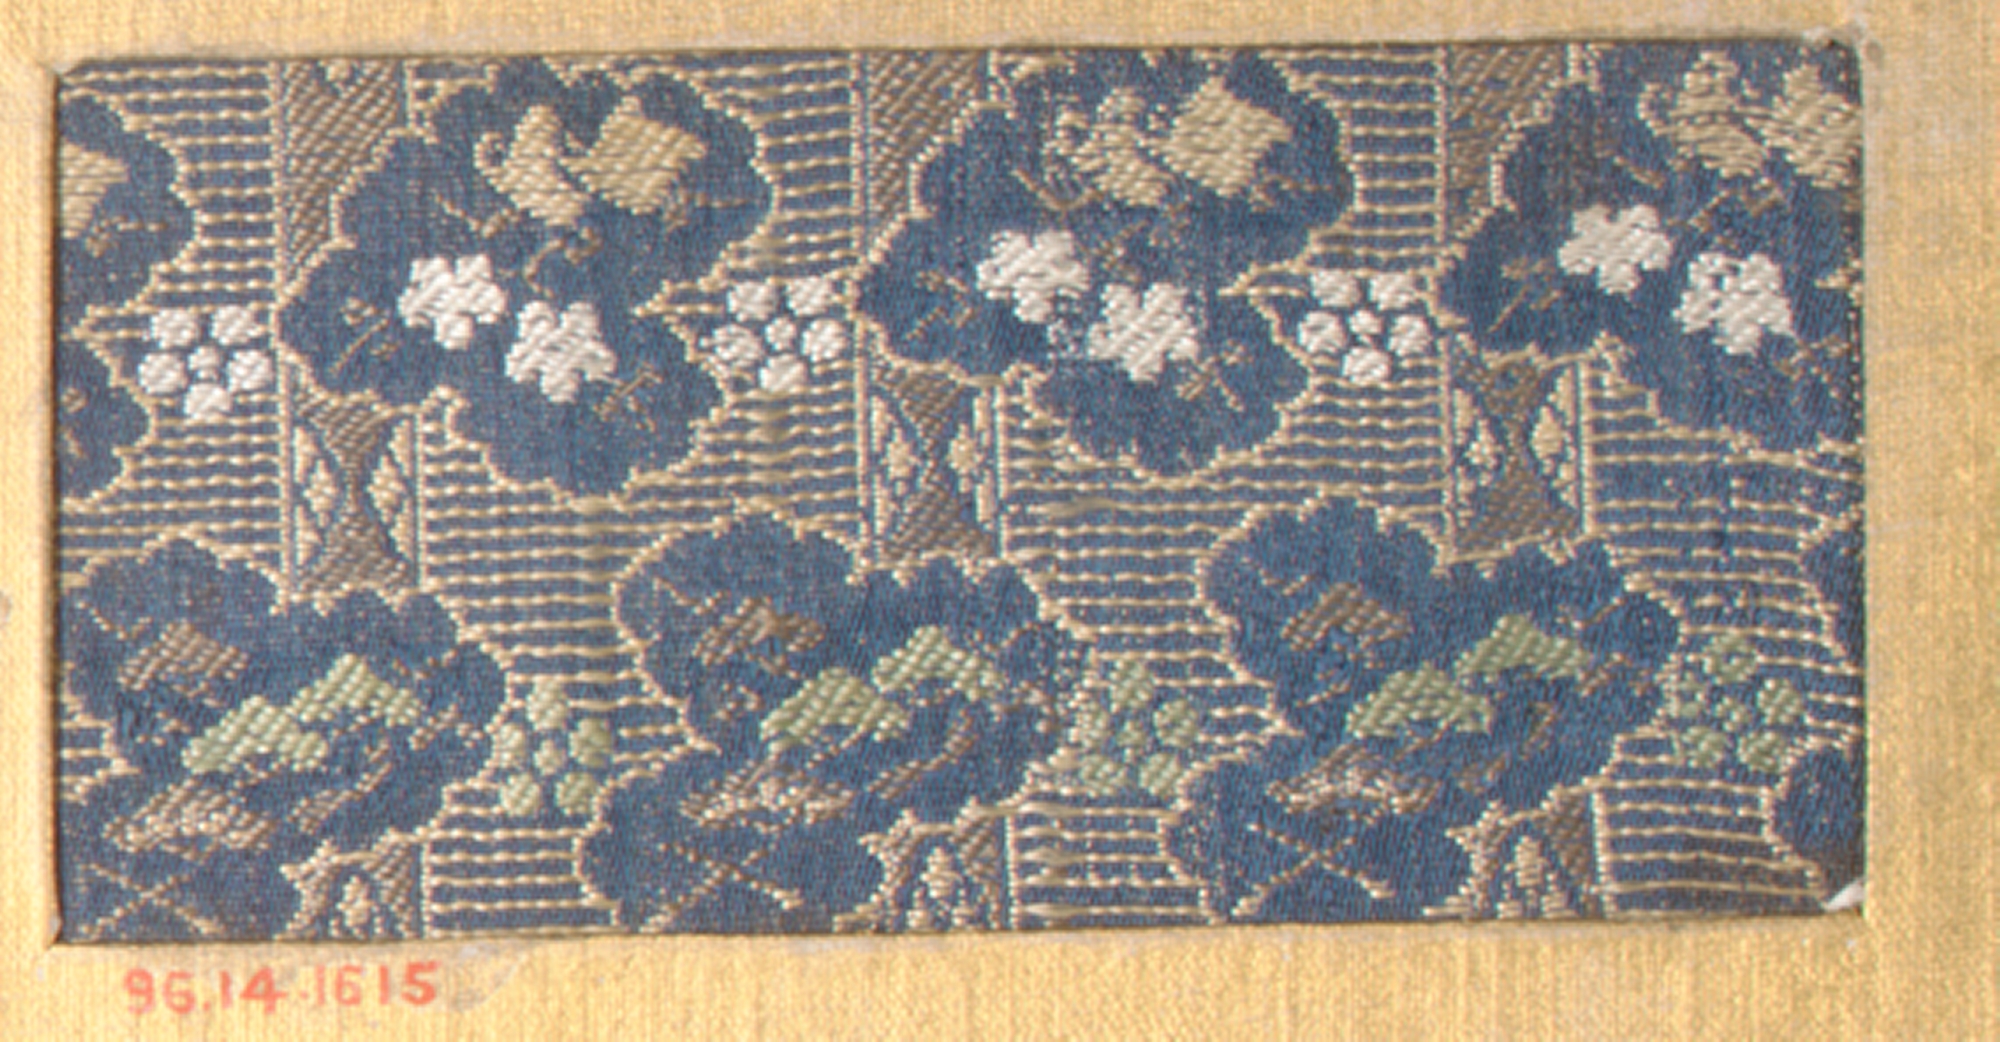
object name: piece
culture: japanese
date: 1701-1900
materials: silk